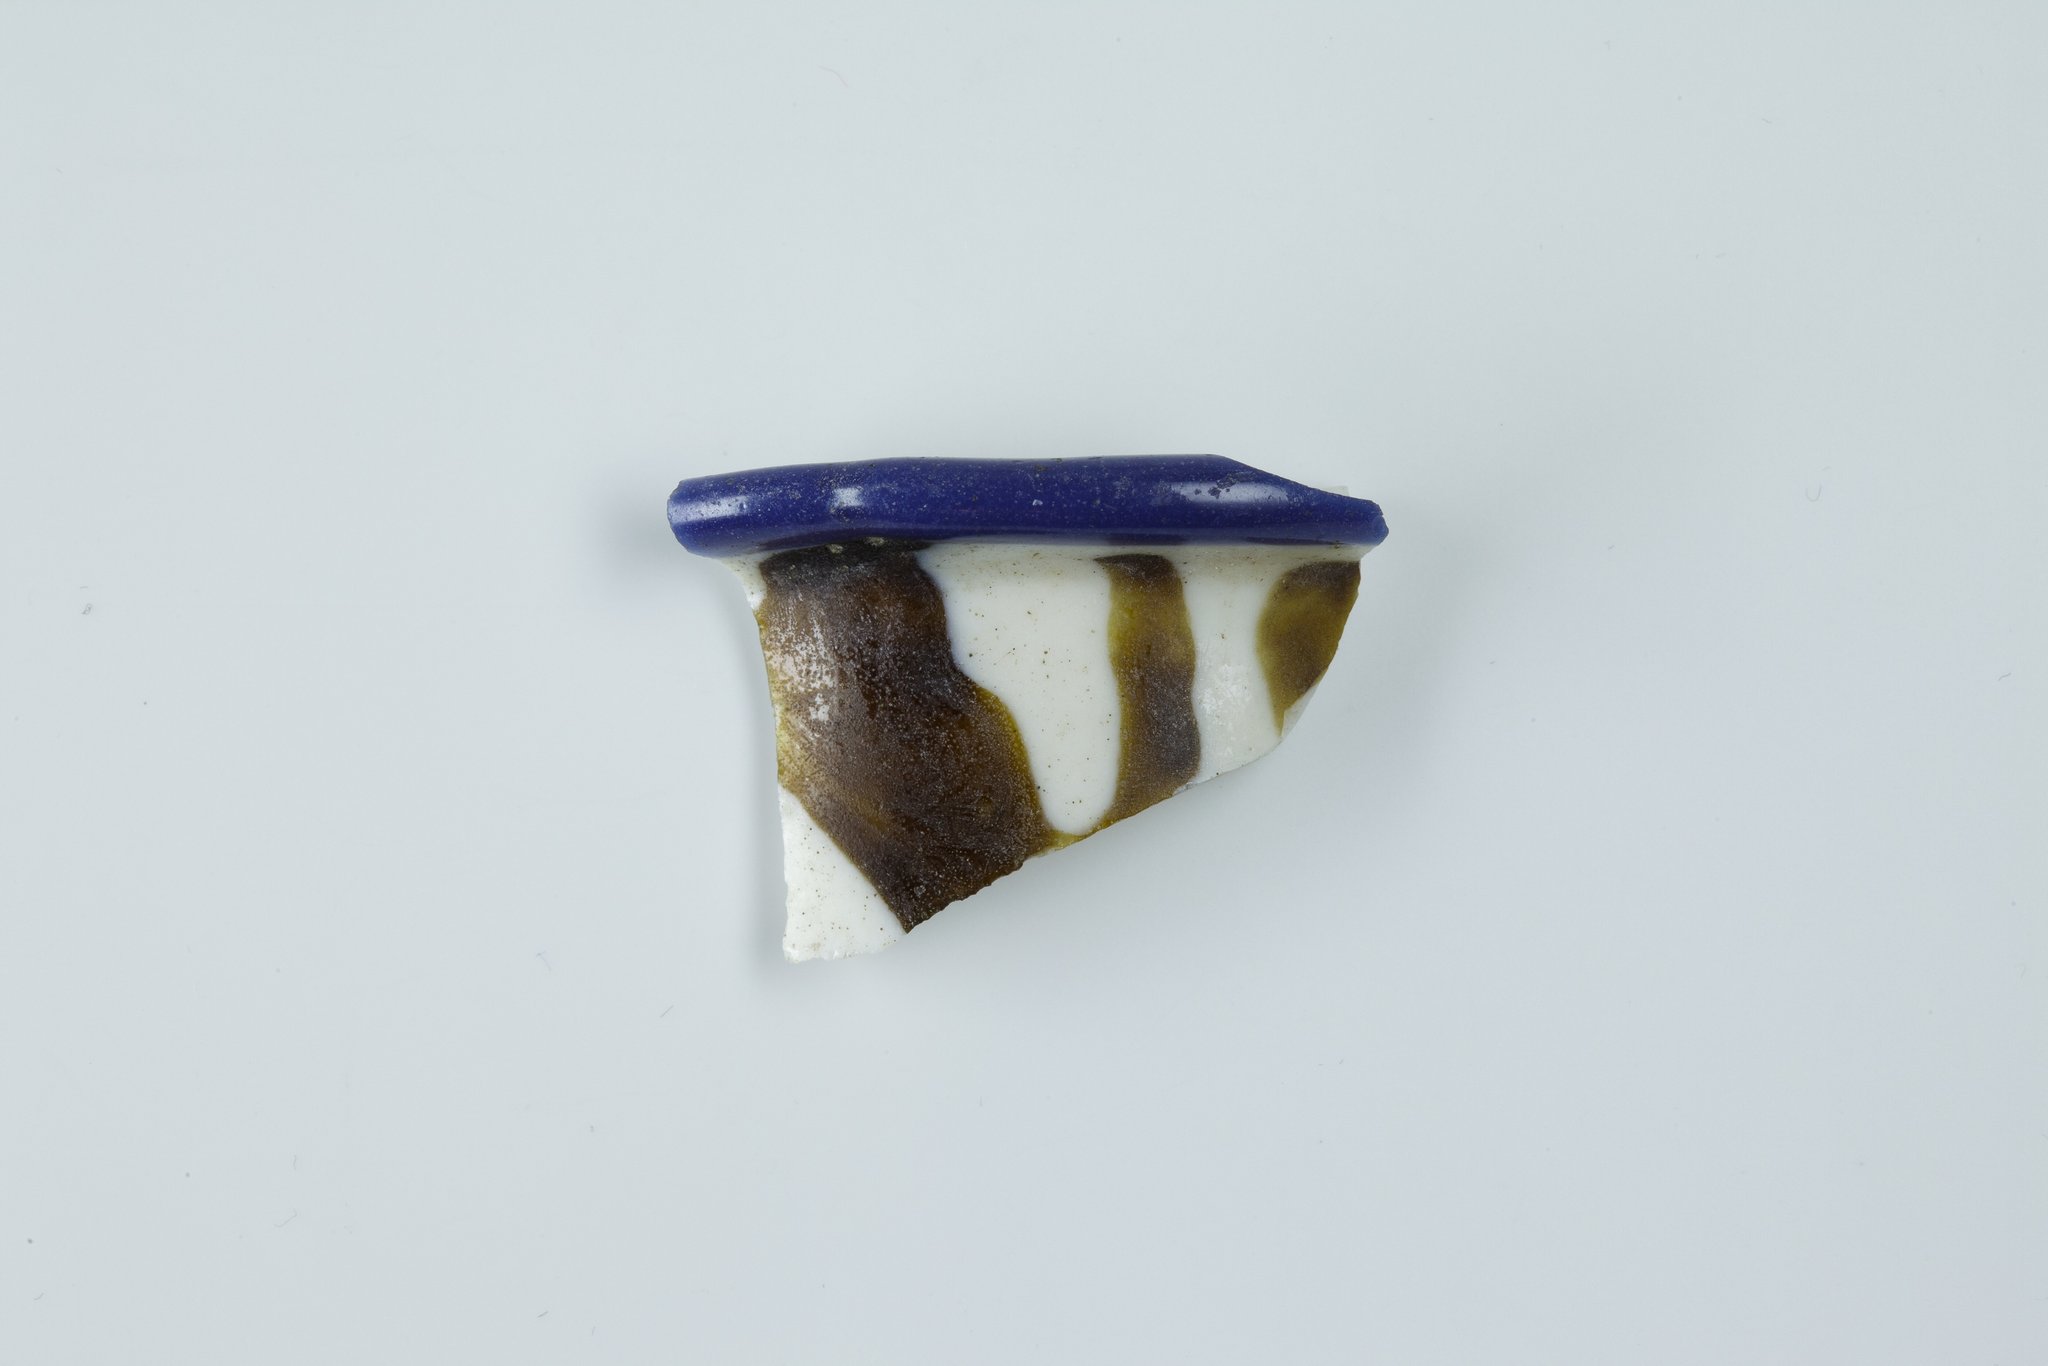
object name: vessel fragment, patterned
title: Rim Fragment of a Glass Vessel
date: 1427-1400 BCE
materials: glass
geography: egypt